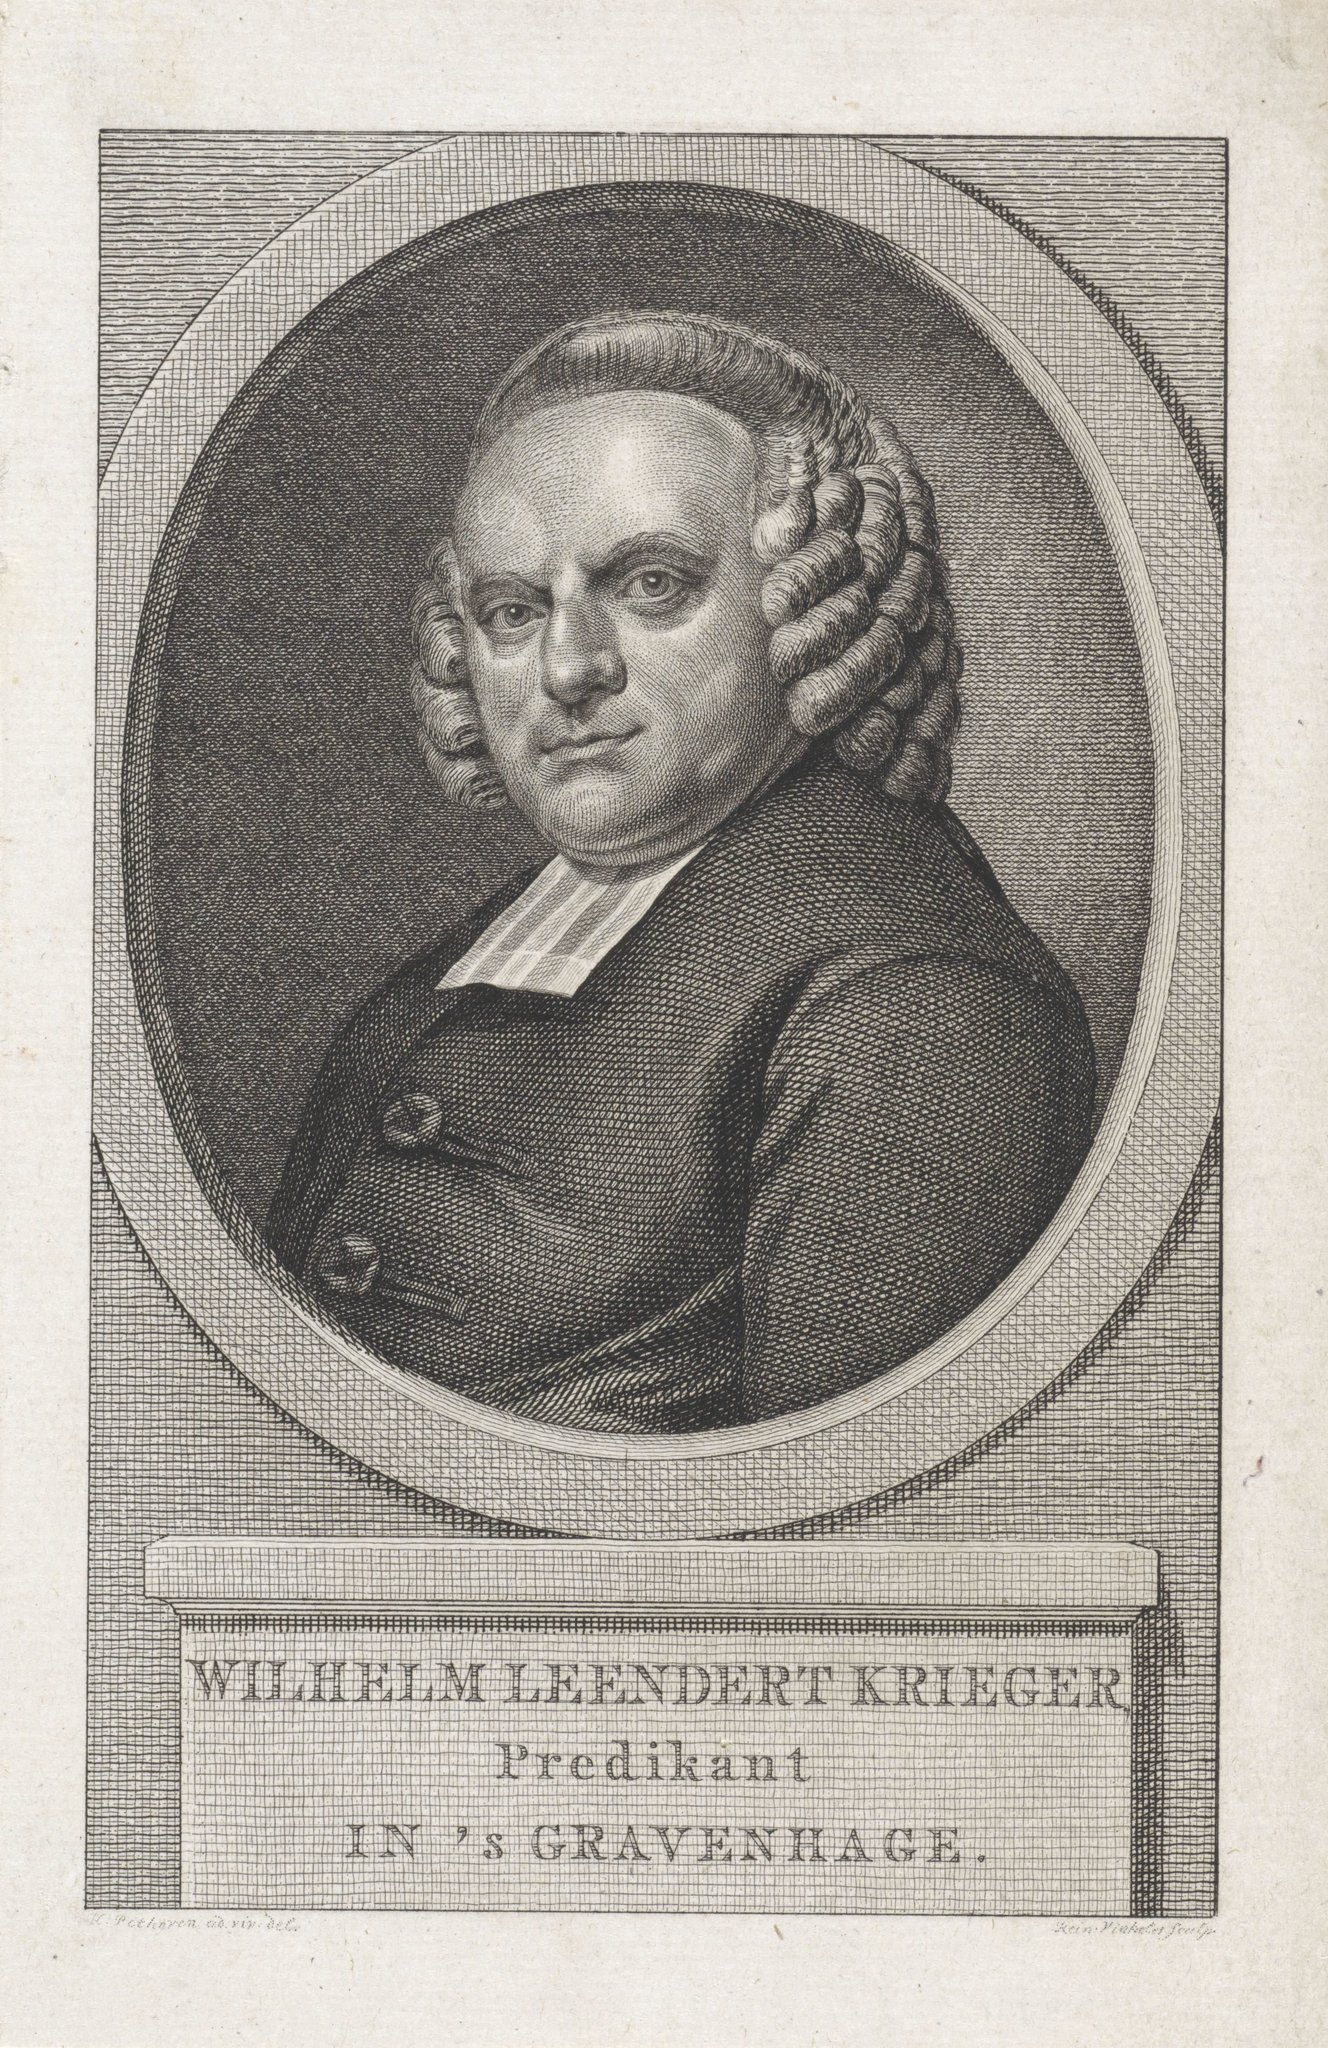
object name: print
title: Portret van Wilhelm Leendert Krieger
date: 1793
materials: paper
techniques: engraving, etching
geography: amsterdam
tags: the hague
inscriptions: collector's mark: Lugt 2228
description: Portret van Wilhelm Leendert Krieger, predikant te Den Haag.